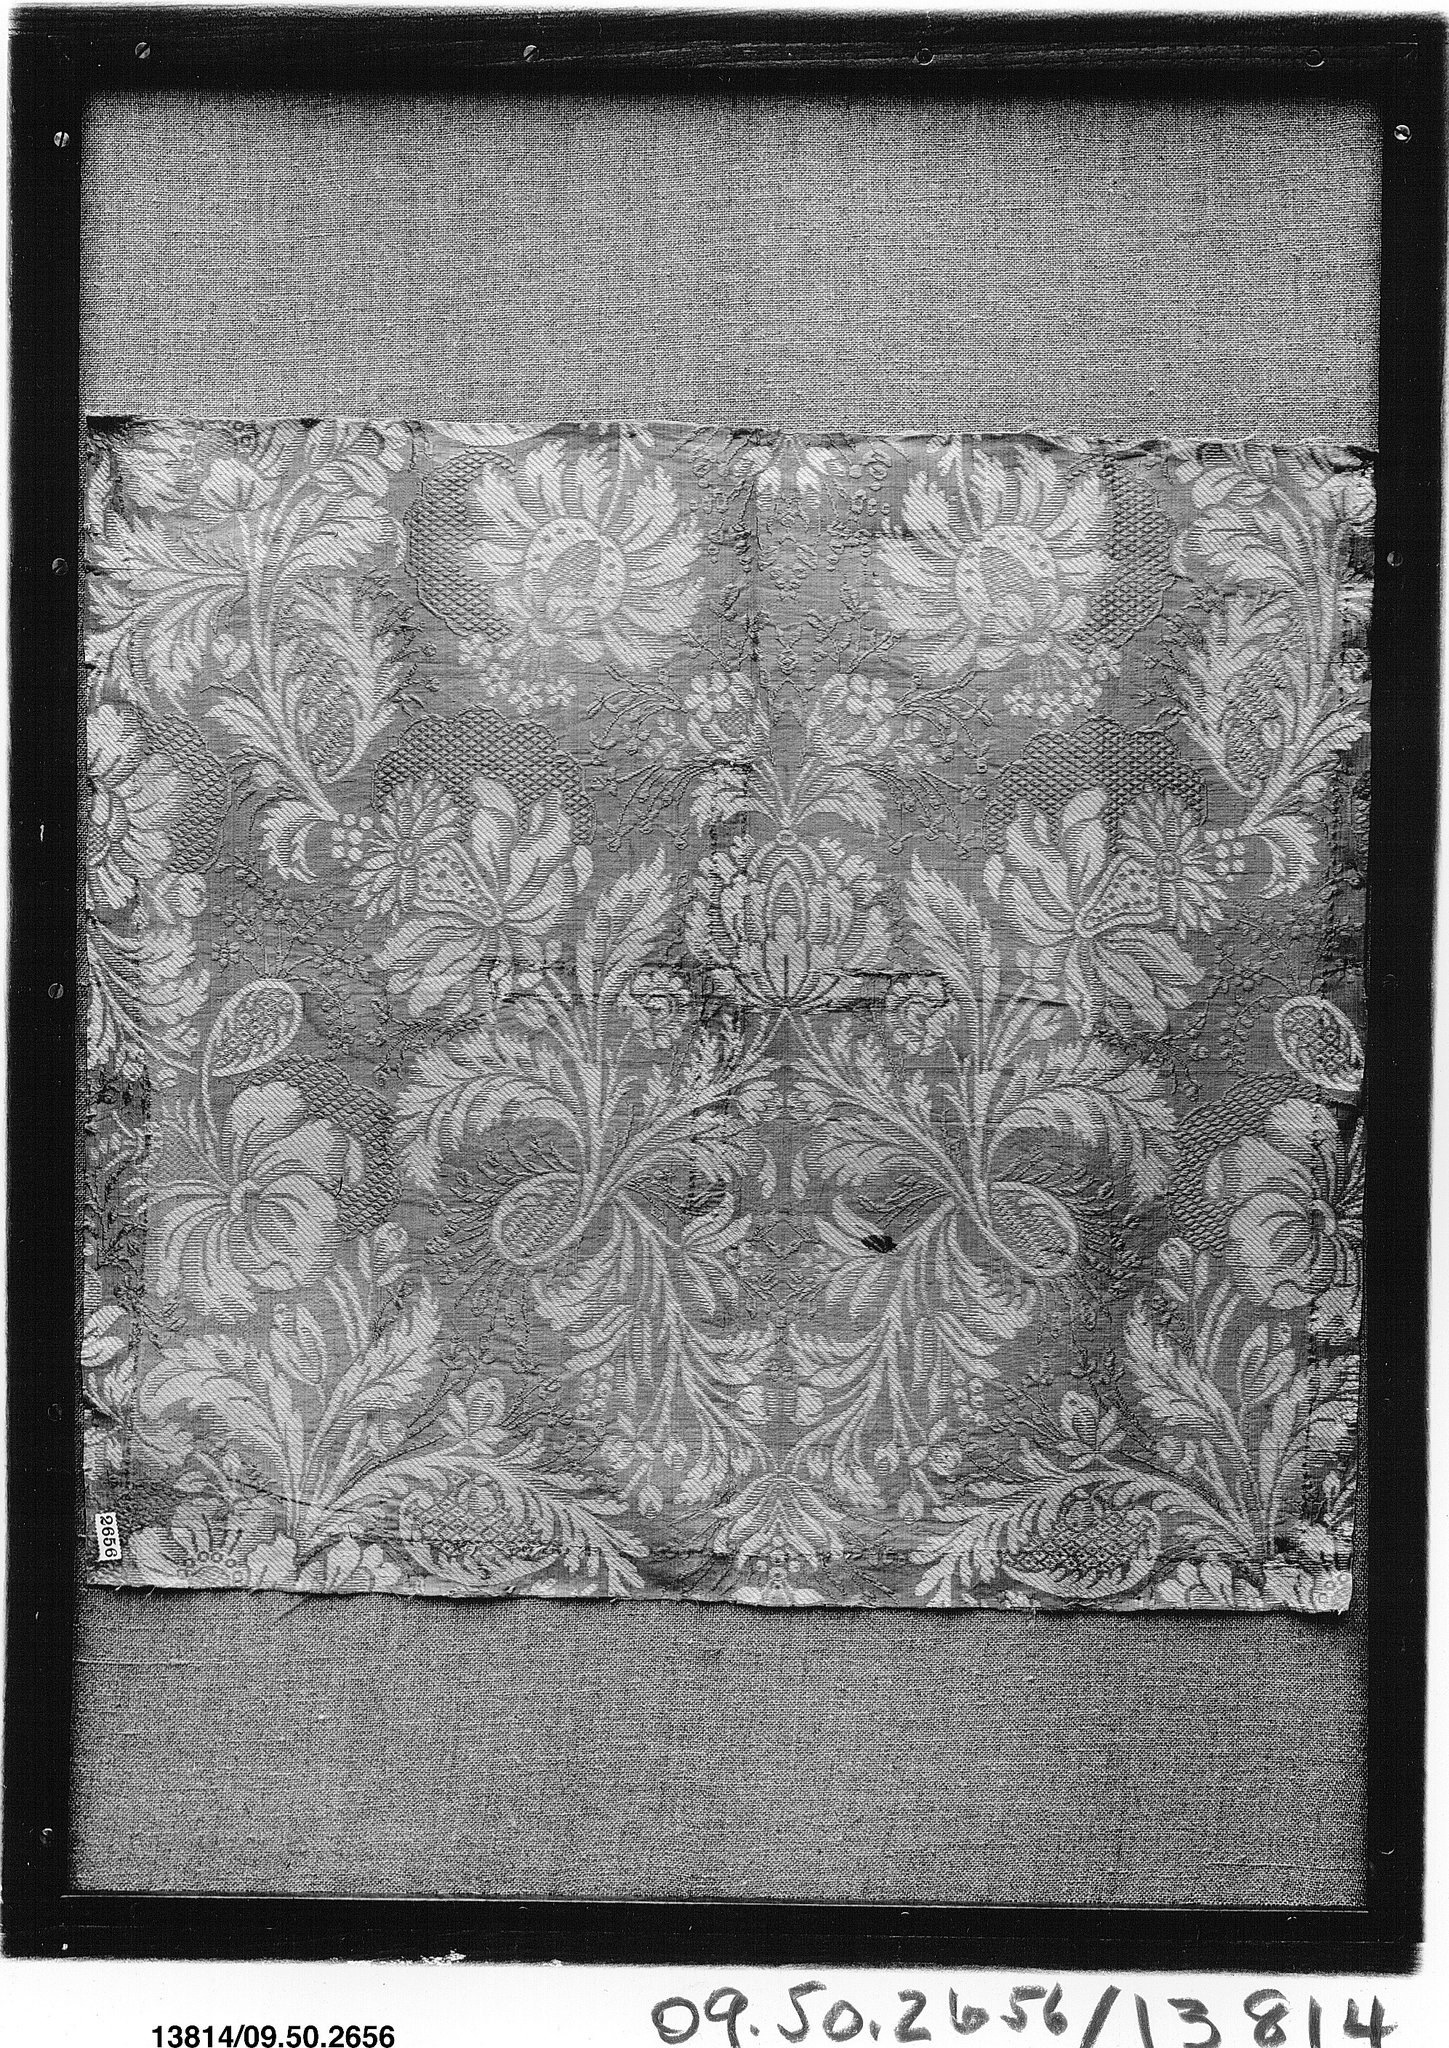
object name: piece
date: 1735-1750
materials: silk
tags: flowers,leaves